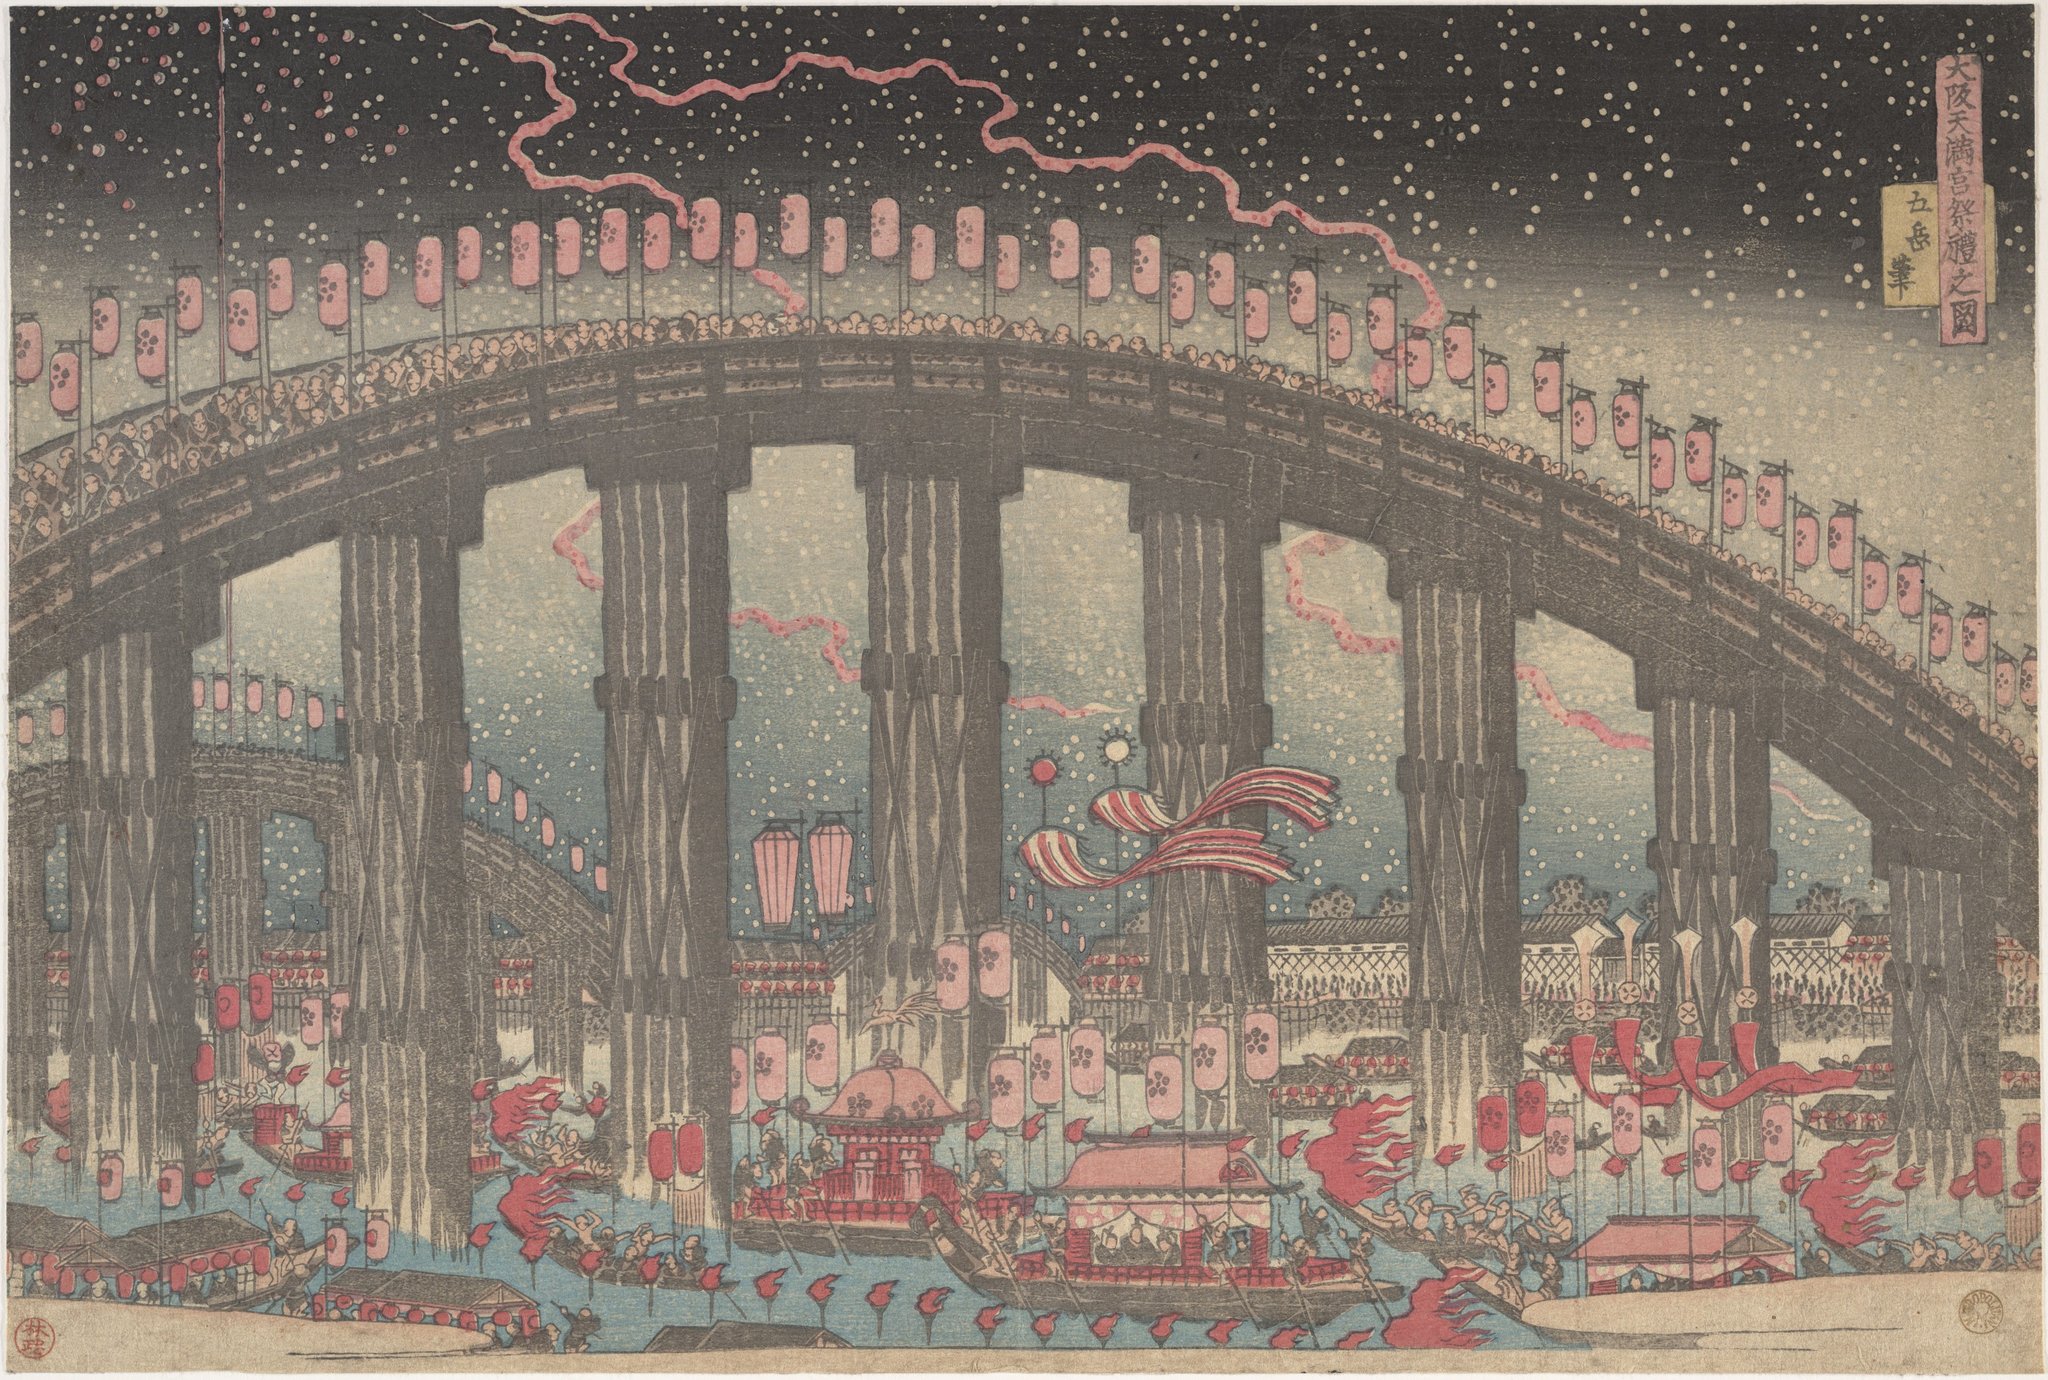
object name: print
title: The Tenmangu Festival at Osaka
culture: japanese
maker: yashima gakutei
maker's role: artist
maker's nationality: japanese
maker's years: 1786-1868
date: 1834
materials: ink, paper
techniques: woodblock print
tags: bridges,stars,crowd,boats